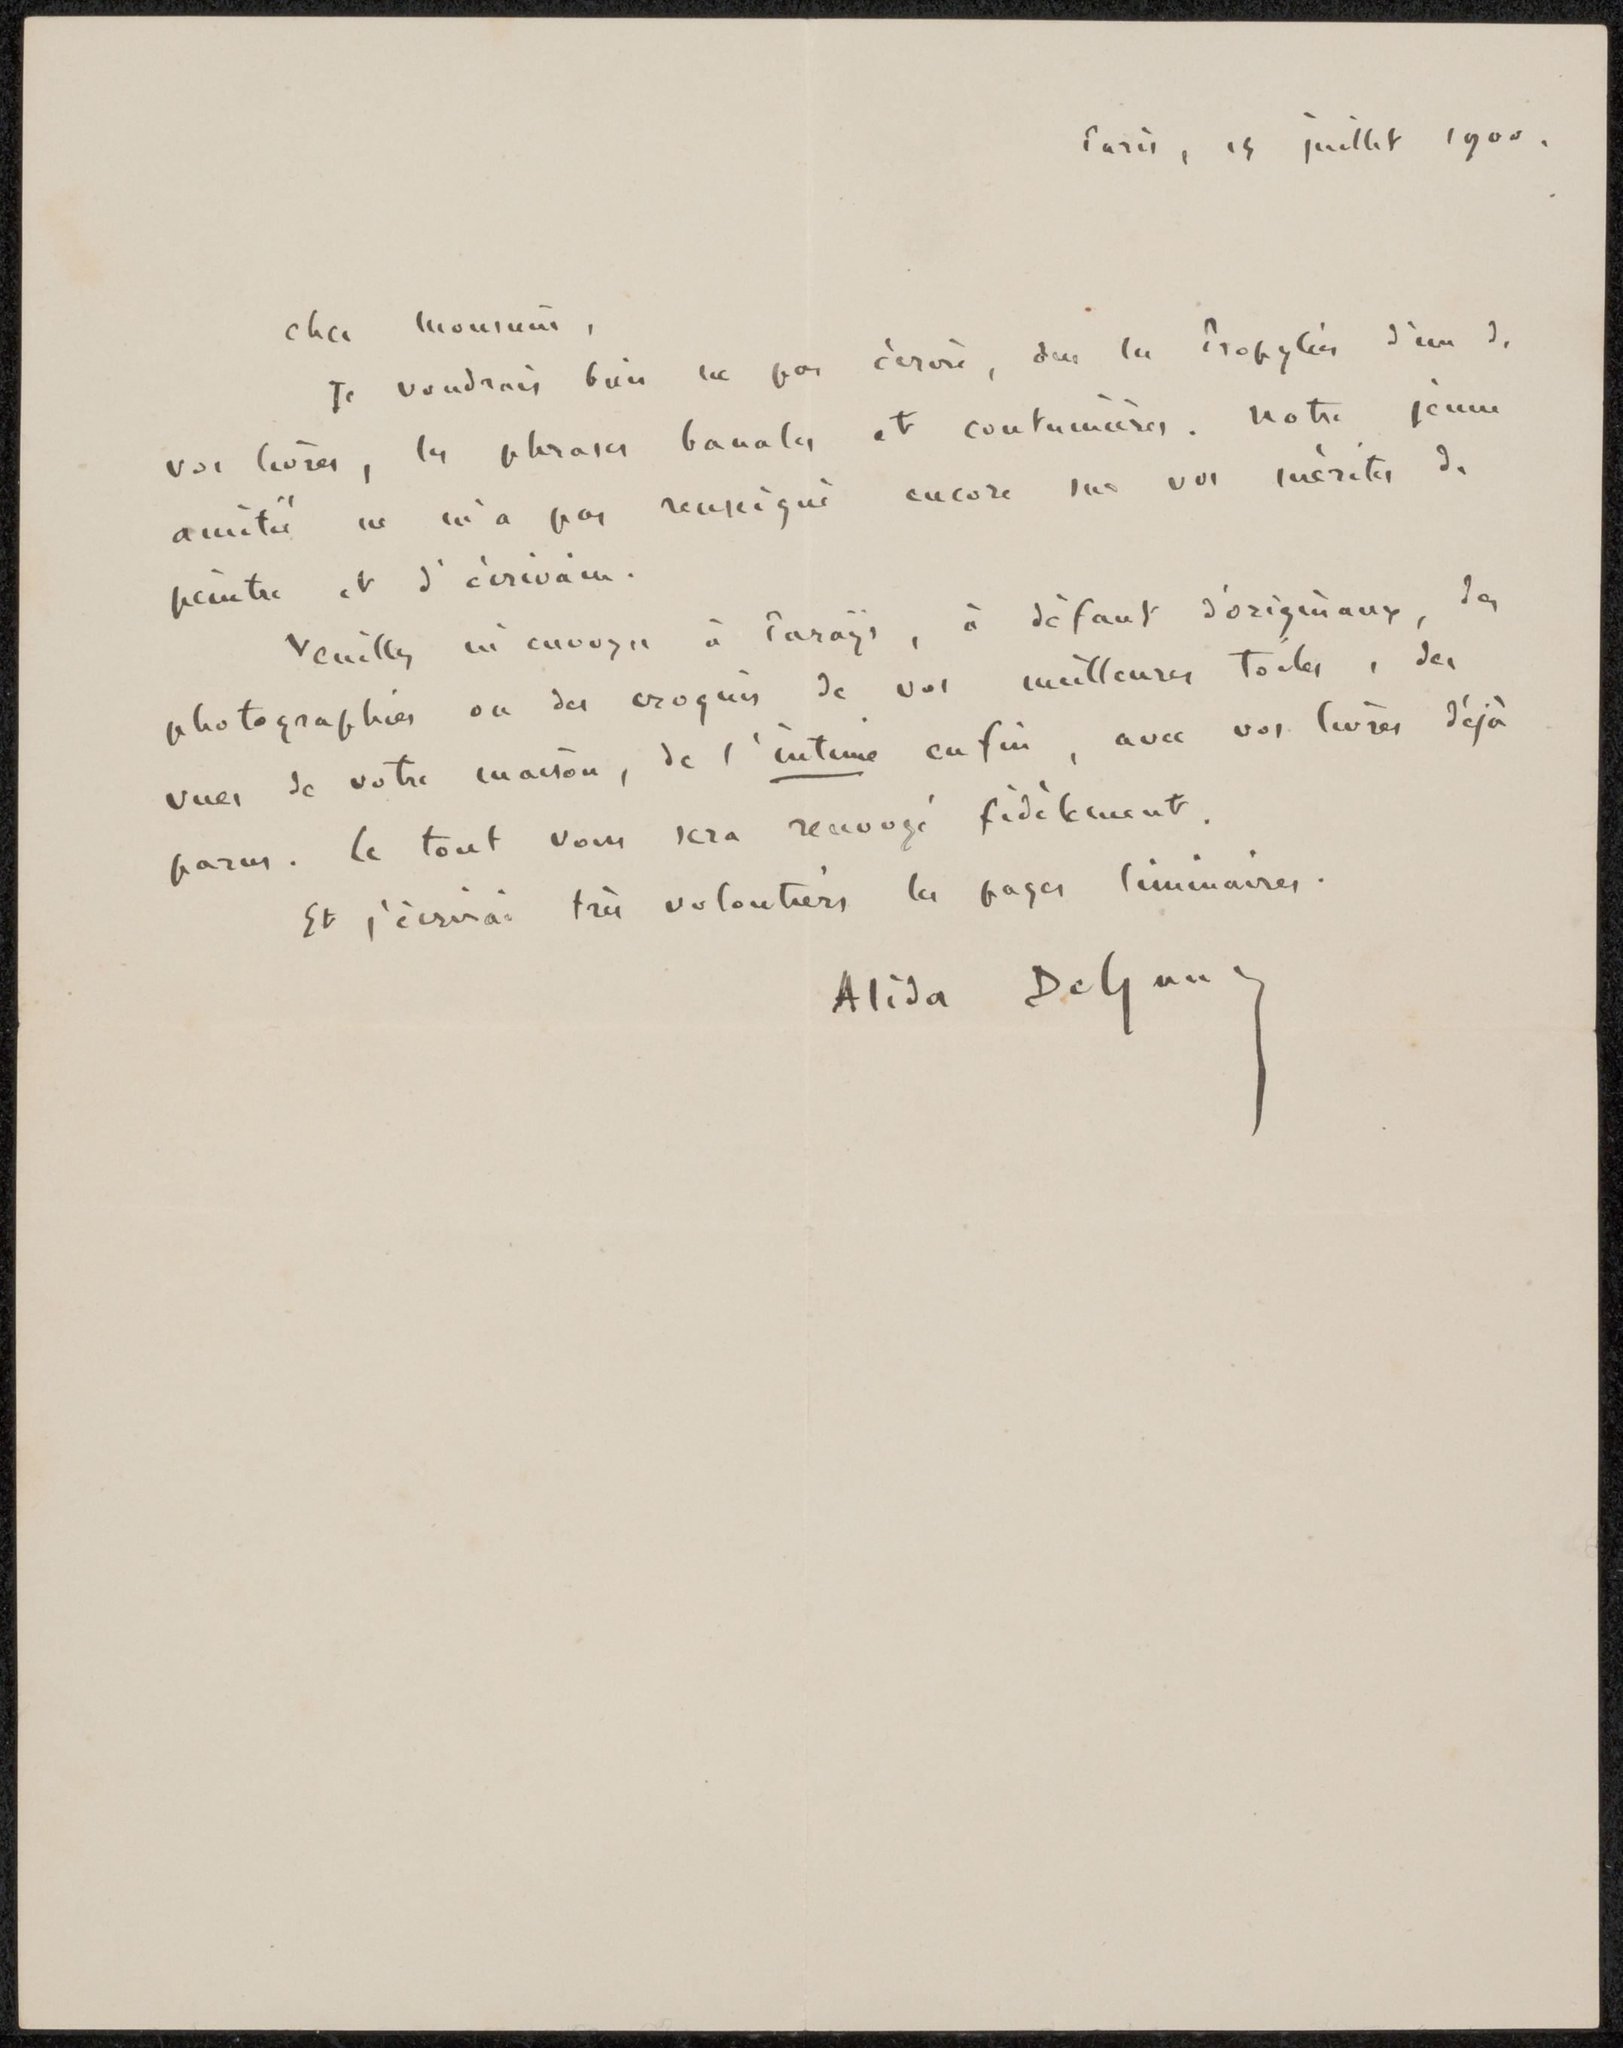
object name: letter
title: Brief aan Philip Zilcken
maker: alidor delzant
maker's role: advocaat, auteur, kunstverzamelaar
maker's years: 1848-1905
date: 1900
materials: ink, paper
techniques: pen, writing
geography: paris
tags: the hague, painter, philip zilcken, literature ~ arts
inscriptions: collector's mark: ‘RPK’, watermark